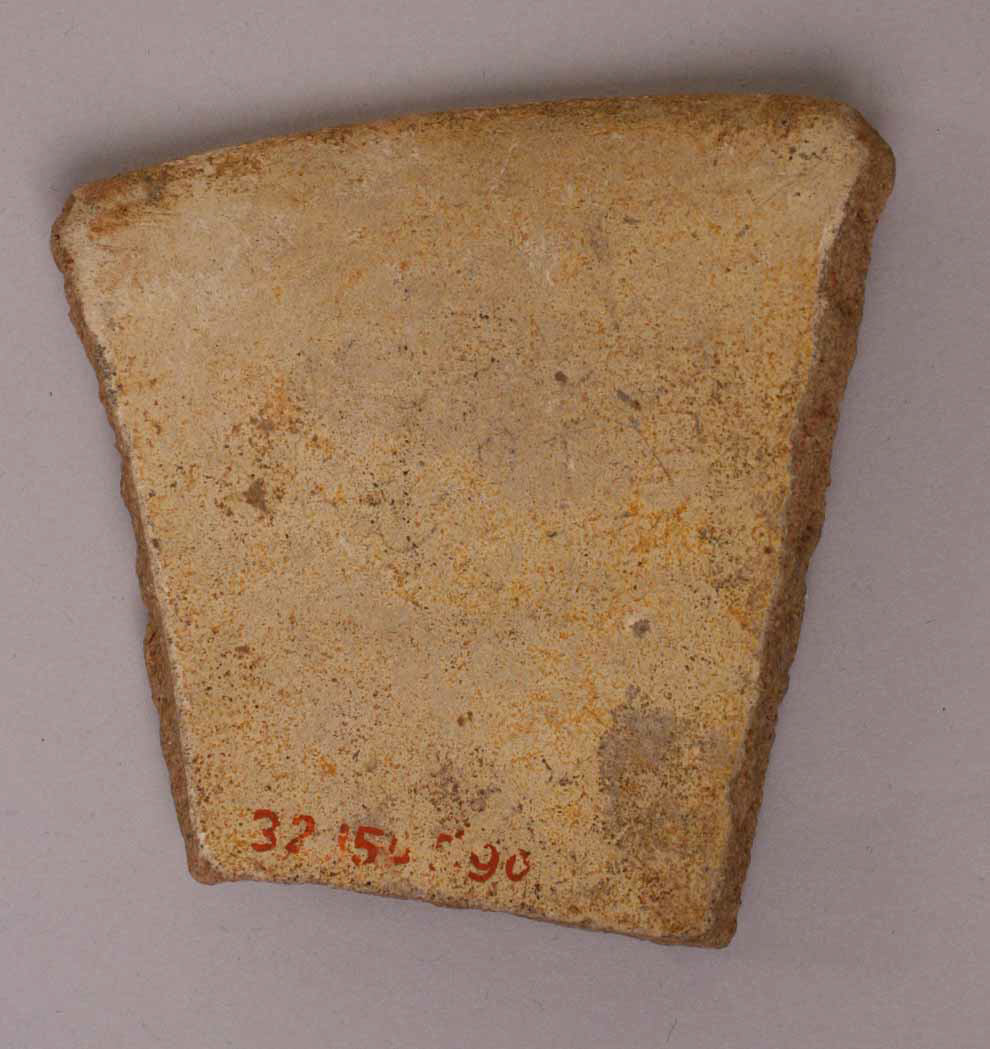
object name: fragment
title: Ceramic Fragment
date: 701-900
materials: earthenware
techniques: glazing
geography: iraq